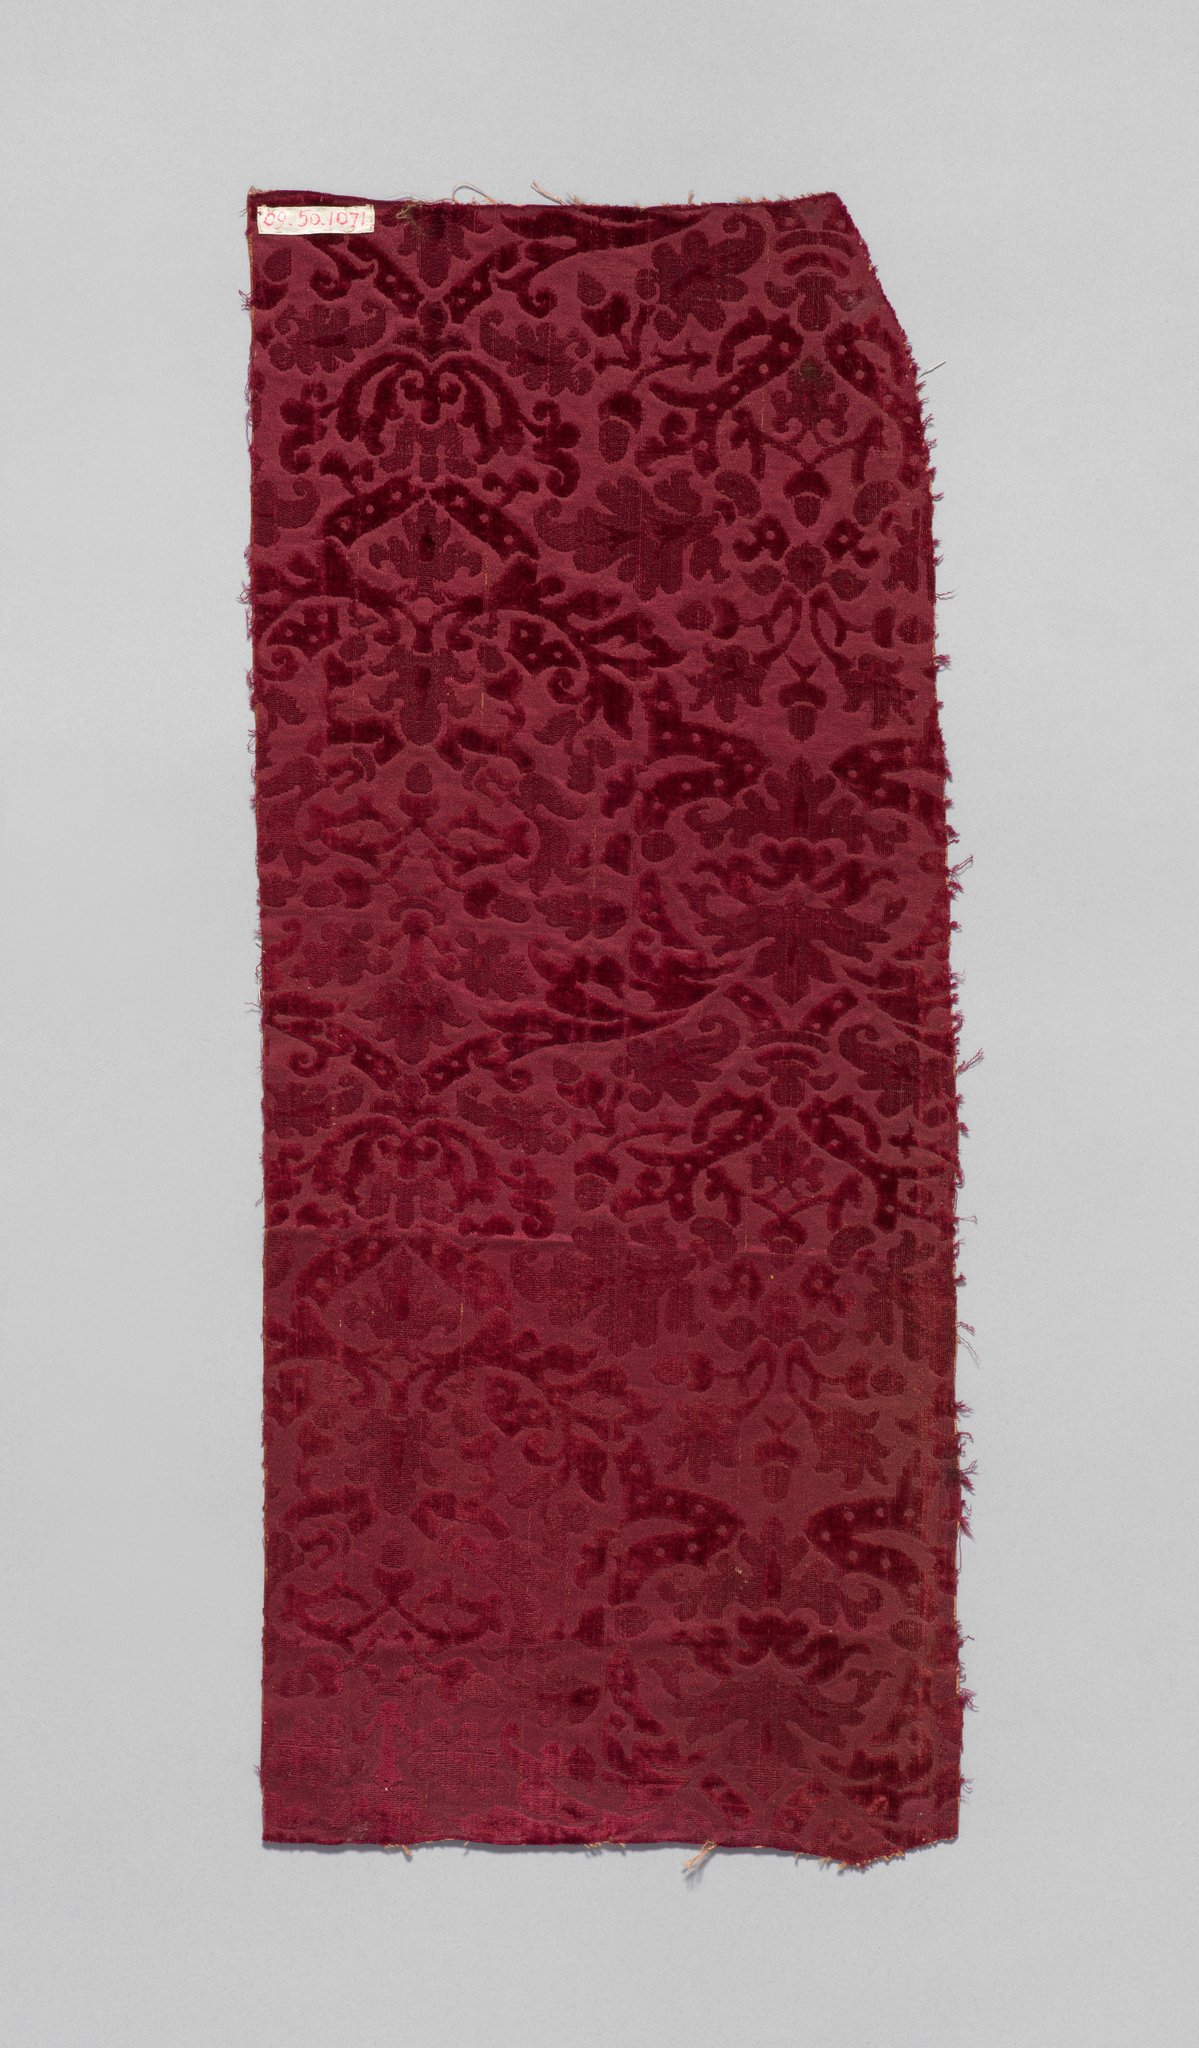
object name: piece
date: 1501-1600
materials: silk